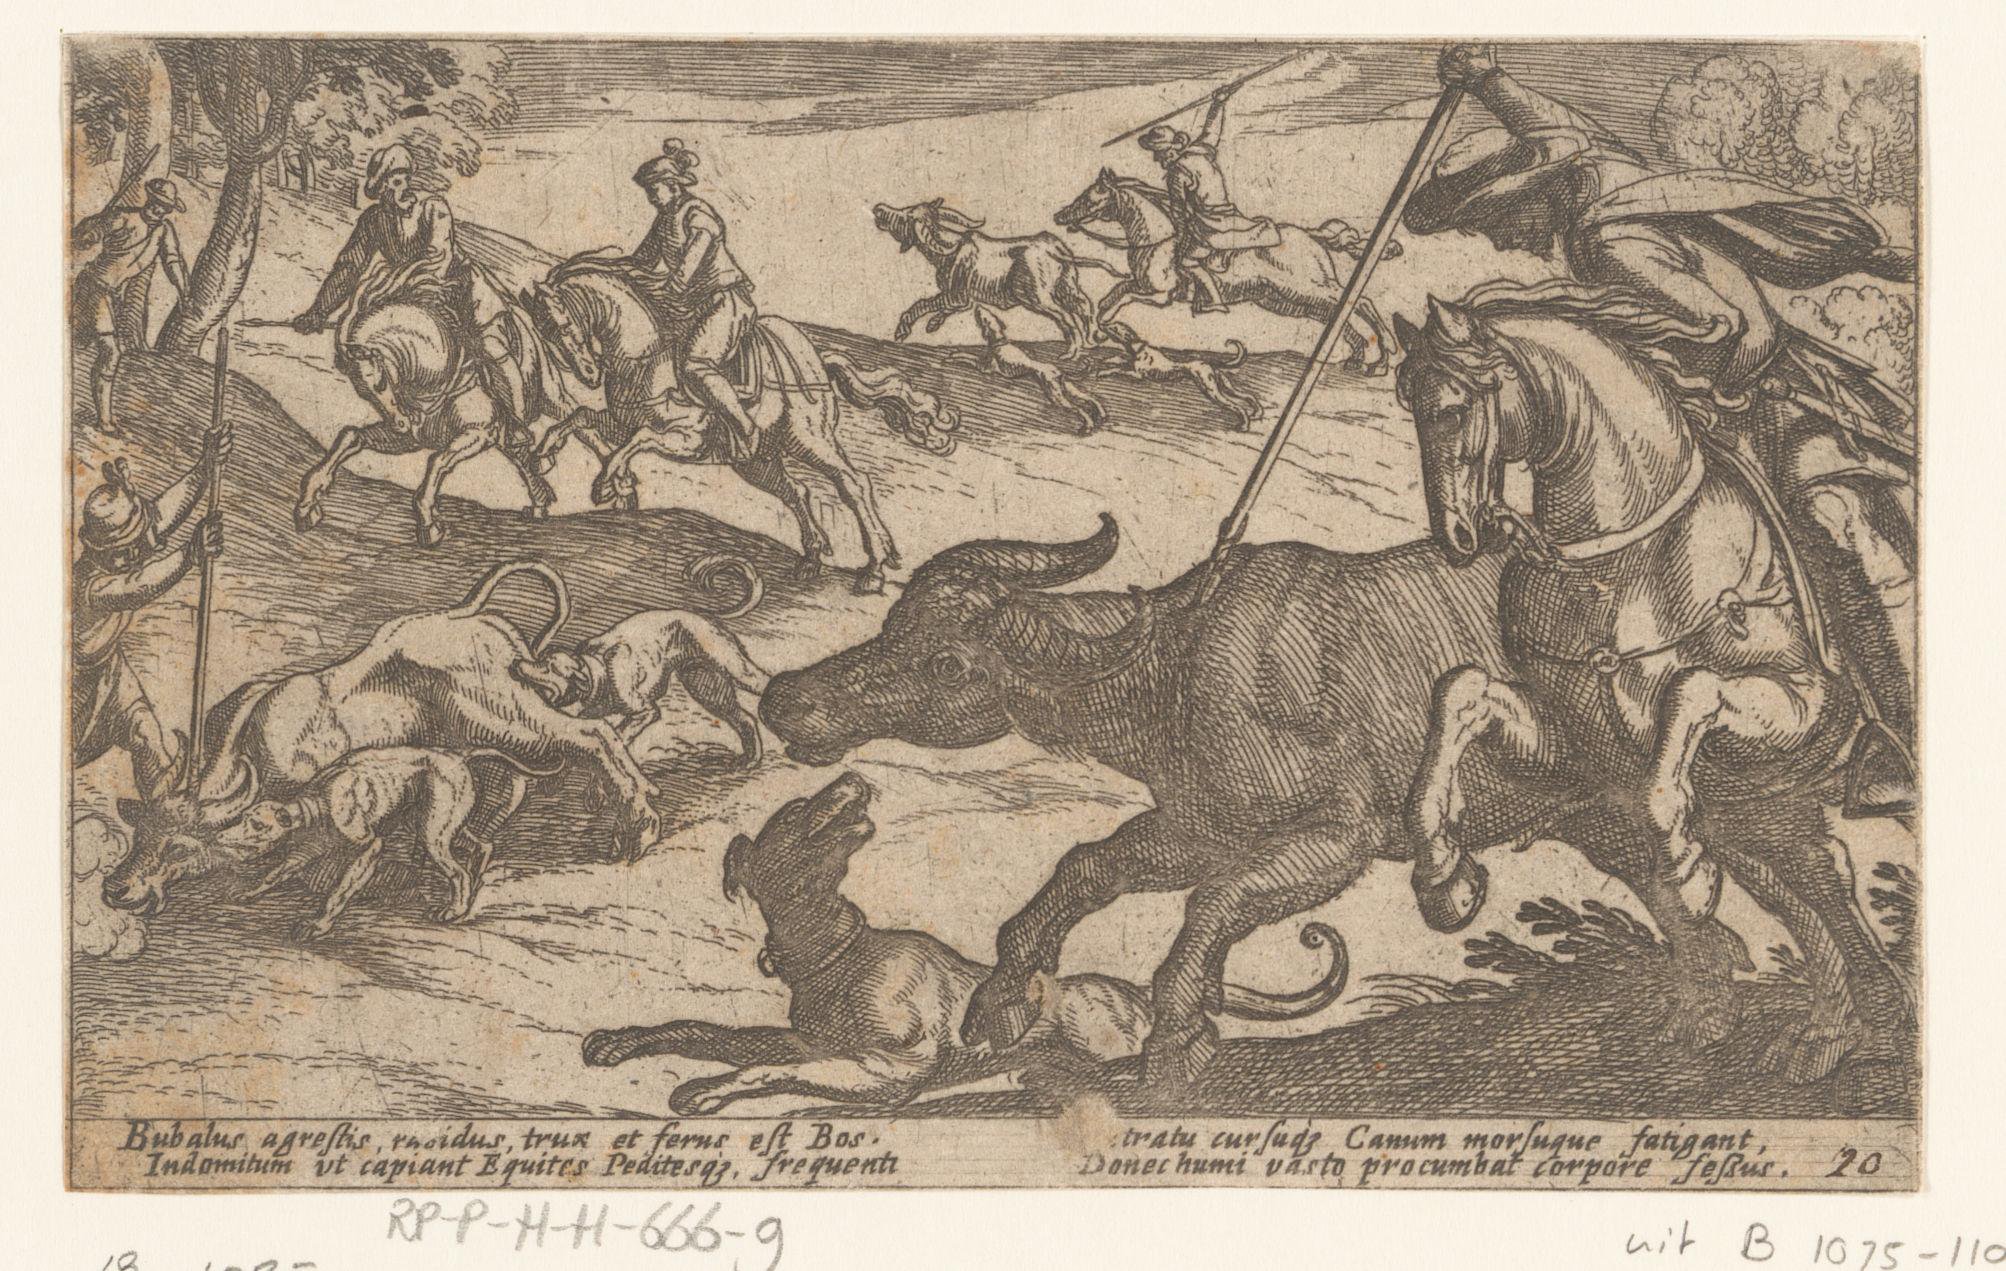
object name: print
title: Jacht op wilde ossen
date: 1605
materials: paper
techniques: etching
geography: italy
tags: hunter, hunters hunting (n.b.: in 1988-1990 this notation denoted the concept of 43c11421 'hunters resting during the hunt'), ox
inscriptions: number: ‘20’, collector's mark: ‘Hinloopen’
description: Landschap met jagers te paard en jachthonden jagend op wilde ossen. Tekst in het Latijn in ondermarge.